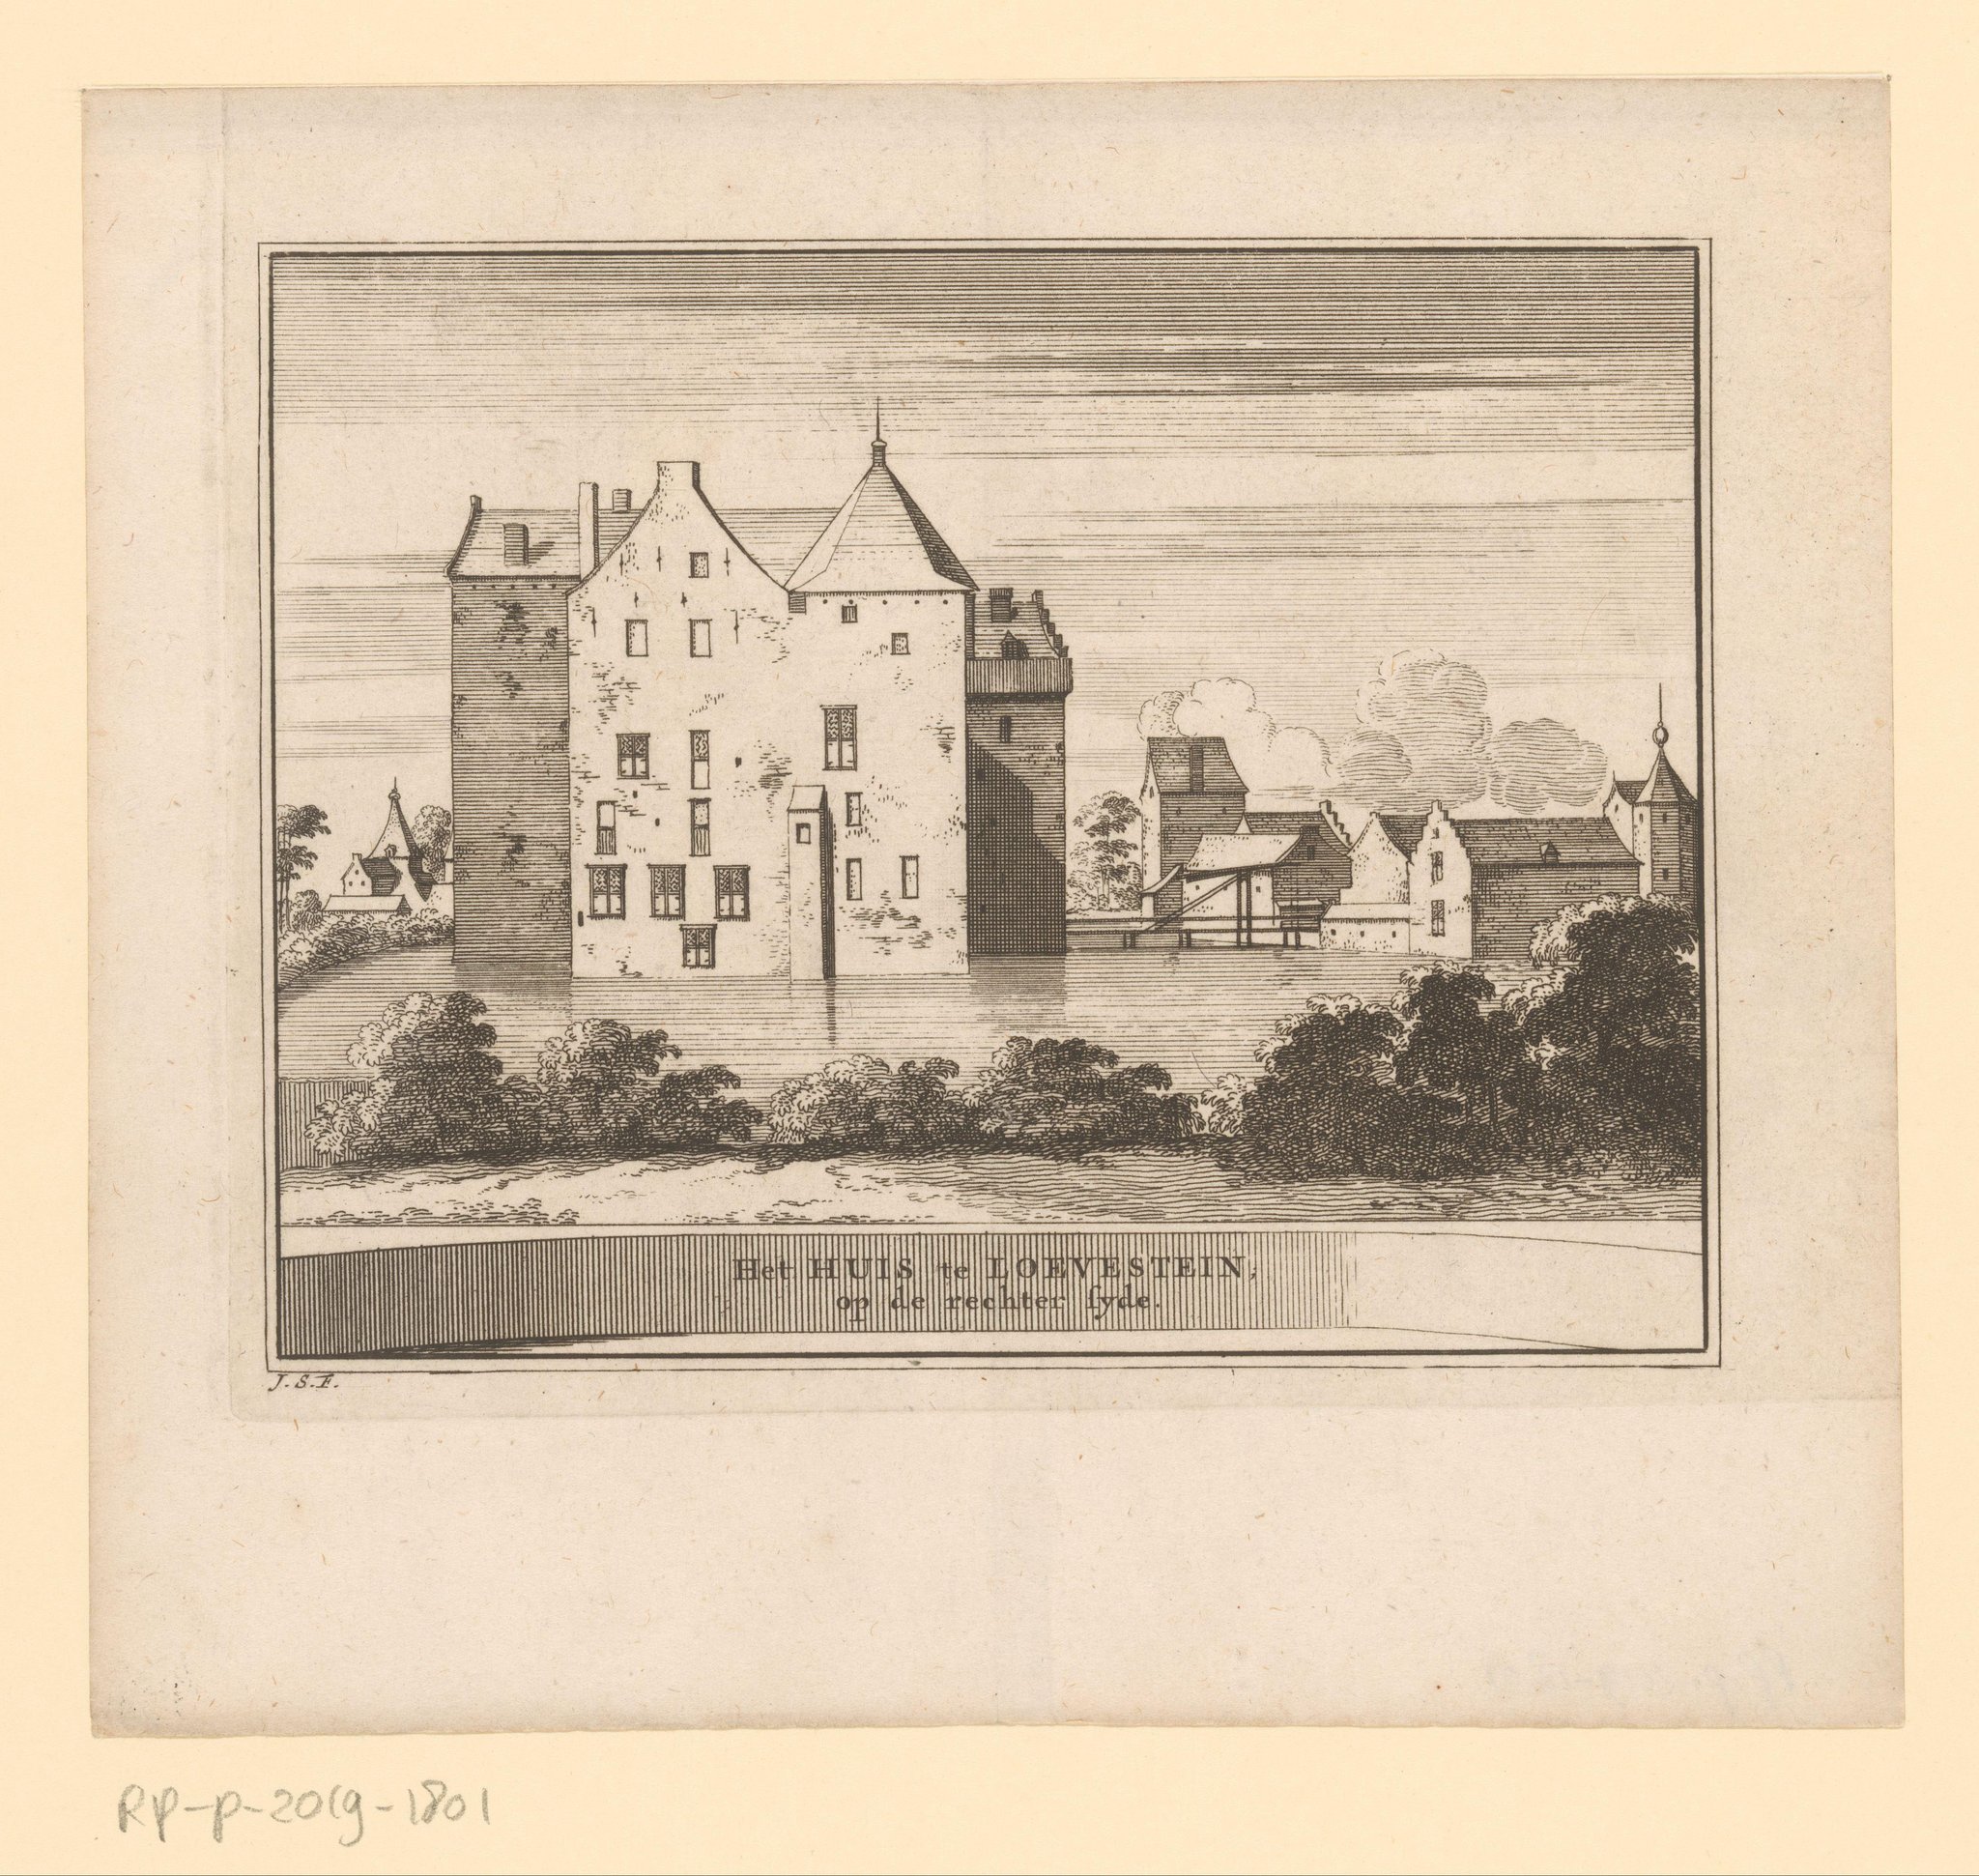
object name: book illustration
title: Het Huis te Loevestein, op de rechter zyde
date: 1711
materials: paper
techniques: etching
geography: amsterdam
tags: castle, loevestein castle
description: Prent voor het eerst gebruikt in: Smids, Ludolph. Schatkamer der Nederlandsse oudheden; of Woordenboek, behelsende Nederlands steden. Amsterdam: Pieter de Coup, 1711, tussen p. 108 en 109. Verscheen daarna mogelijk in heruitgaven van dit werk in 1737 en 1774. In 1721 verscheen er een uitgave met alleen de prenten: Nederlandsche oudheden, bestaande in zestig verbeeldingen (...) gelegen in Holland, 't Sticht van Utrecht en Gelderland enz. Amsterdam: Hendrik Bosch, 1721.